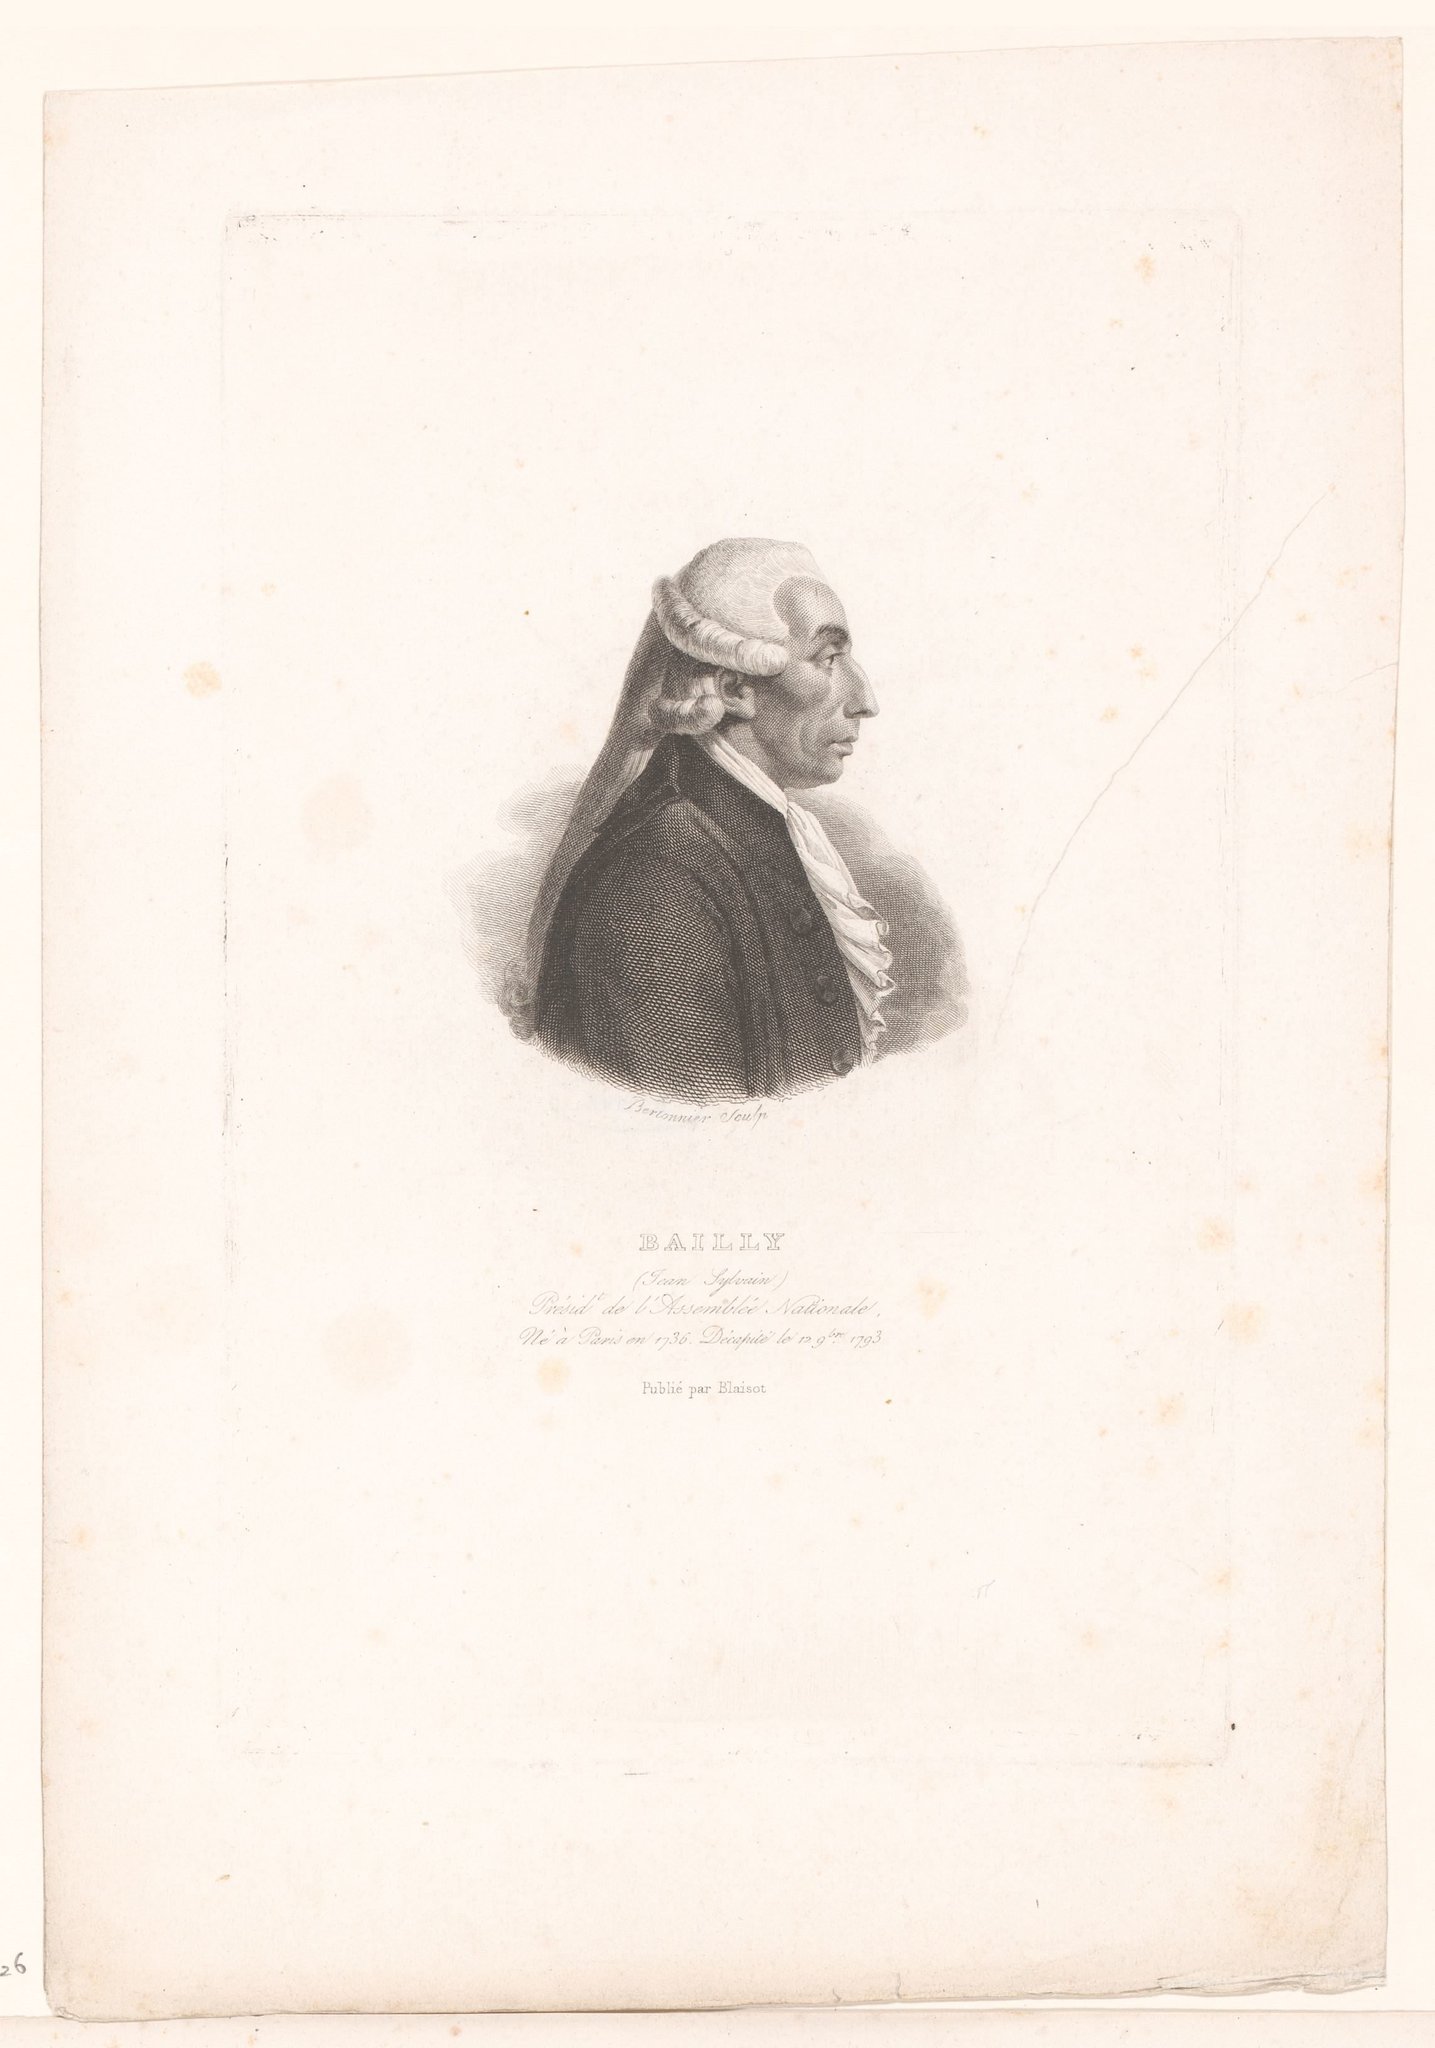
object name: print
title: Bailly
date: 1801-1847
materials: paper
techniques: etching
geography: france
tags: paris, politician, mayor, historical persons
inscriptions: collector's mark: Lugt 2228